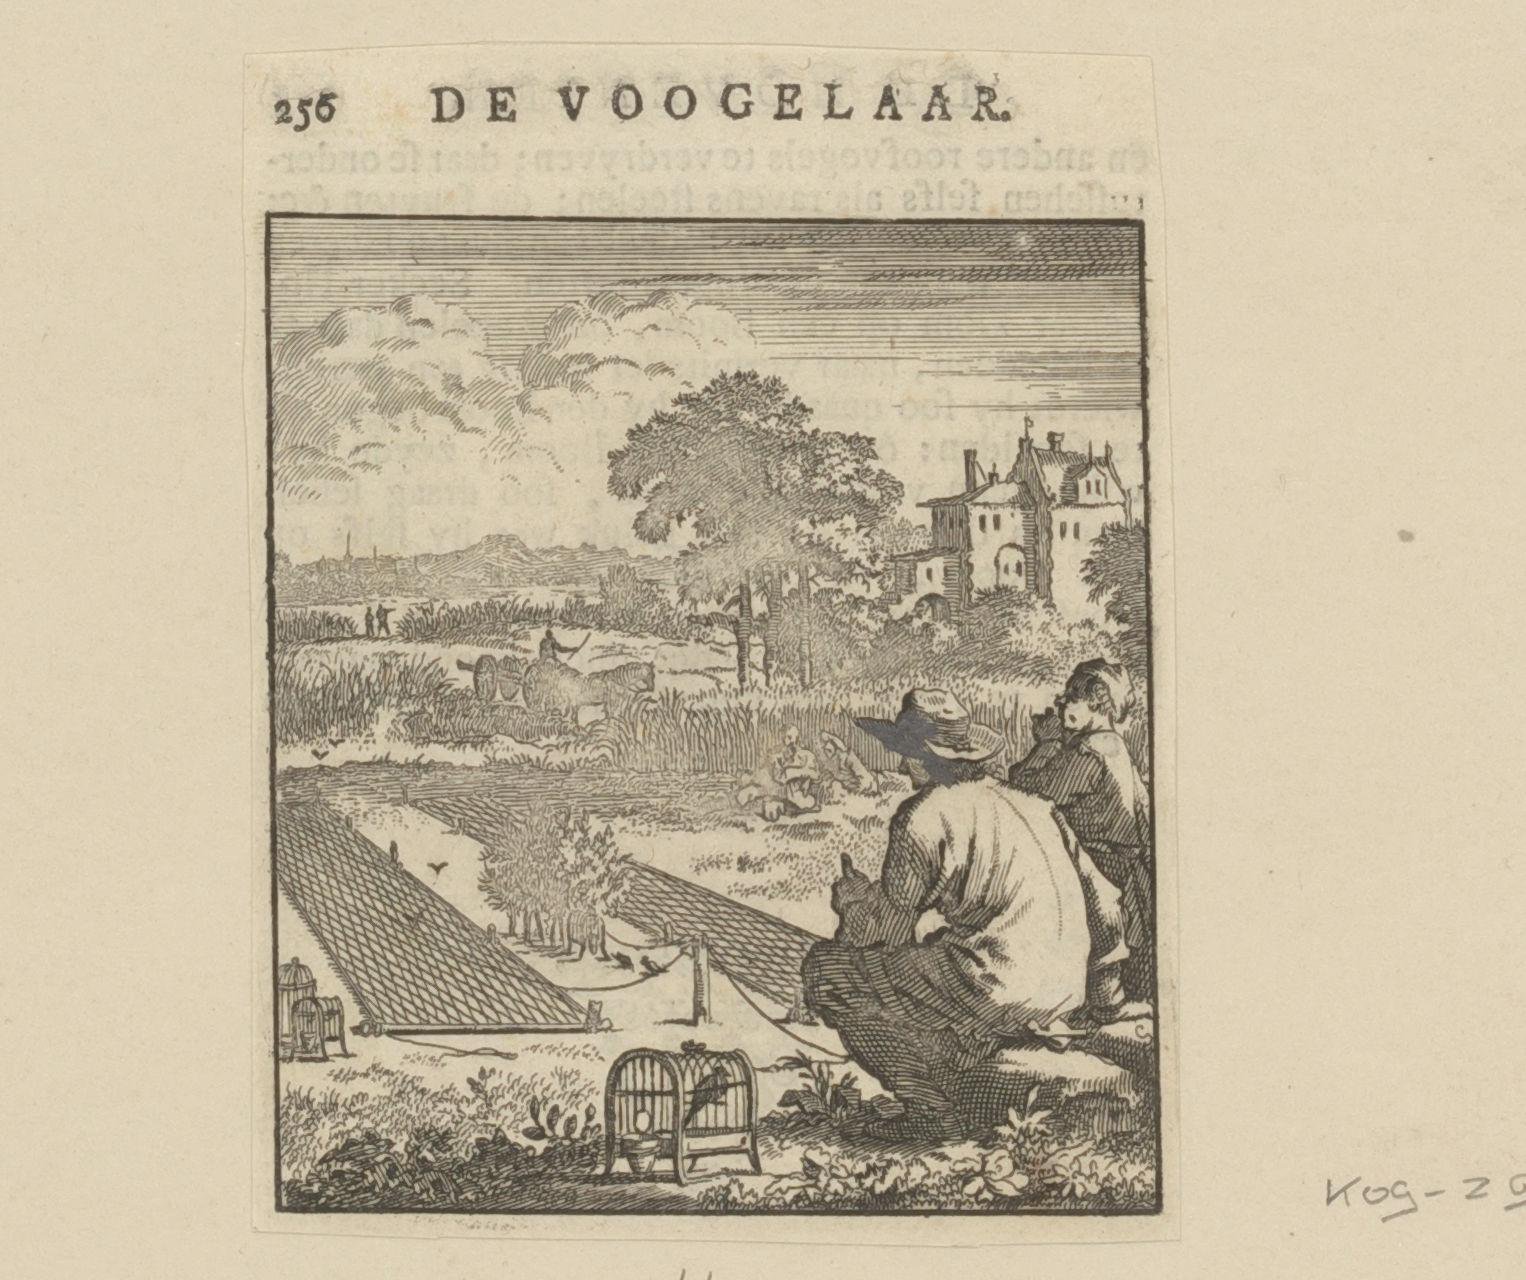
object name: print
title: De Voogelaar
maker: Anonymous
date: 1719-1759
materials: paper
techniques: etching, letterpress printing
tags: bird hunting, bird in a cage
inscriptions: collector's mark: Lugt 1641, stamp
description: Prent met andere letterzetting gebruikt in: St. Clara, Abraham van. Iets voor allen. [Vertaald door] J. le Long. Amsterdam: Janssoons van Waesberge, 1719, dl. 2. En in: St. Clara, Abraham van. Iets voor allen. [Vertaald door] J. le Long. Amsterdam: Jan Roman de Jonge, 1741, dl. 2. En in: St. Clara, Abraham van. Iets voor allen. [Vertaald door] J. le Long. Amsterdam: Jan Roman, 1759, dl. 2. Huidige prent uit een andere editie. Naar een prent van: Jan Luyken.